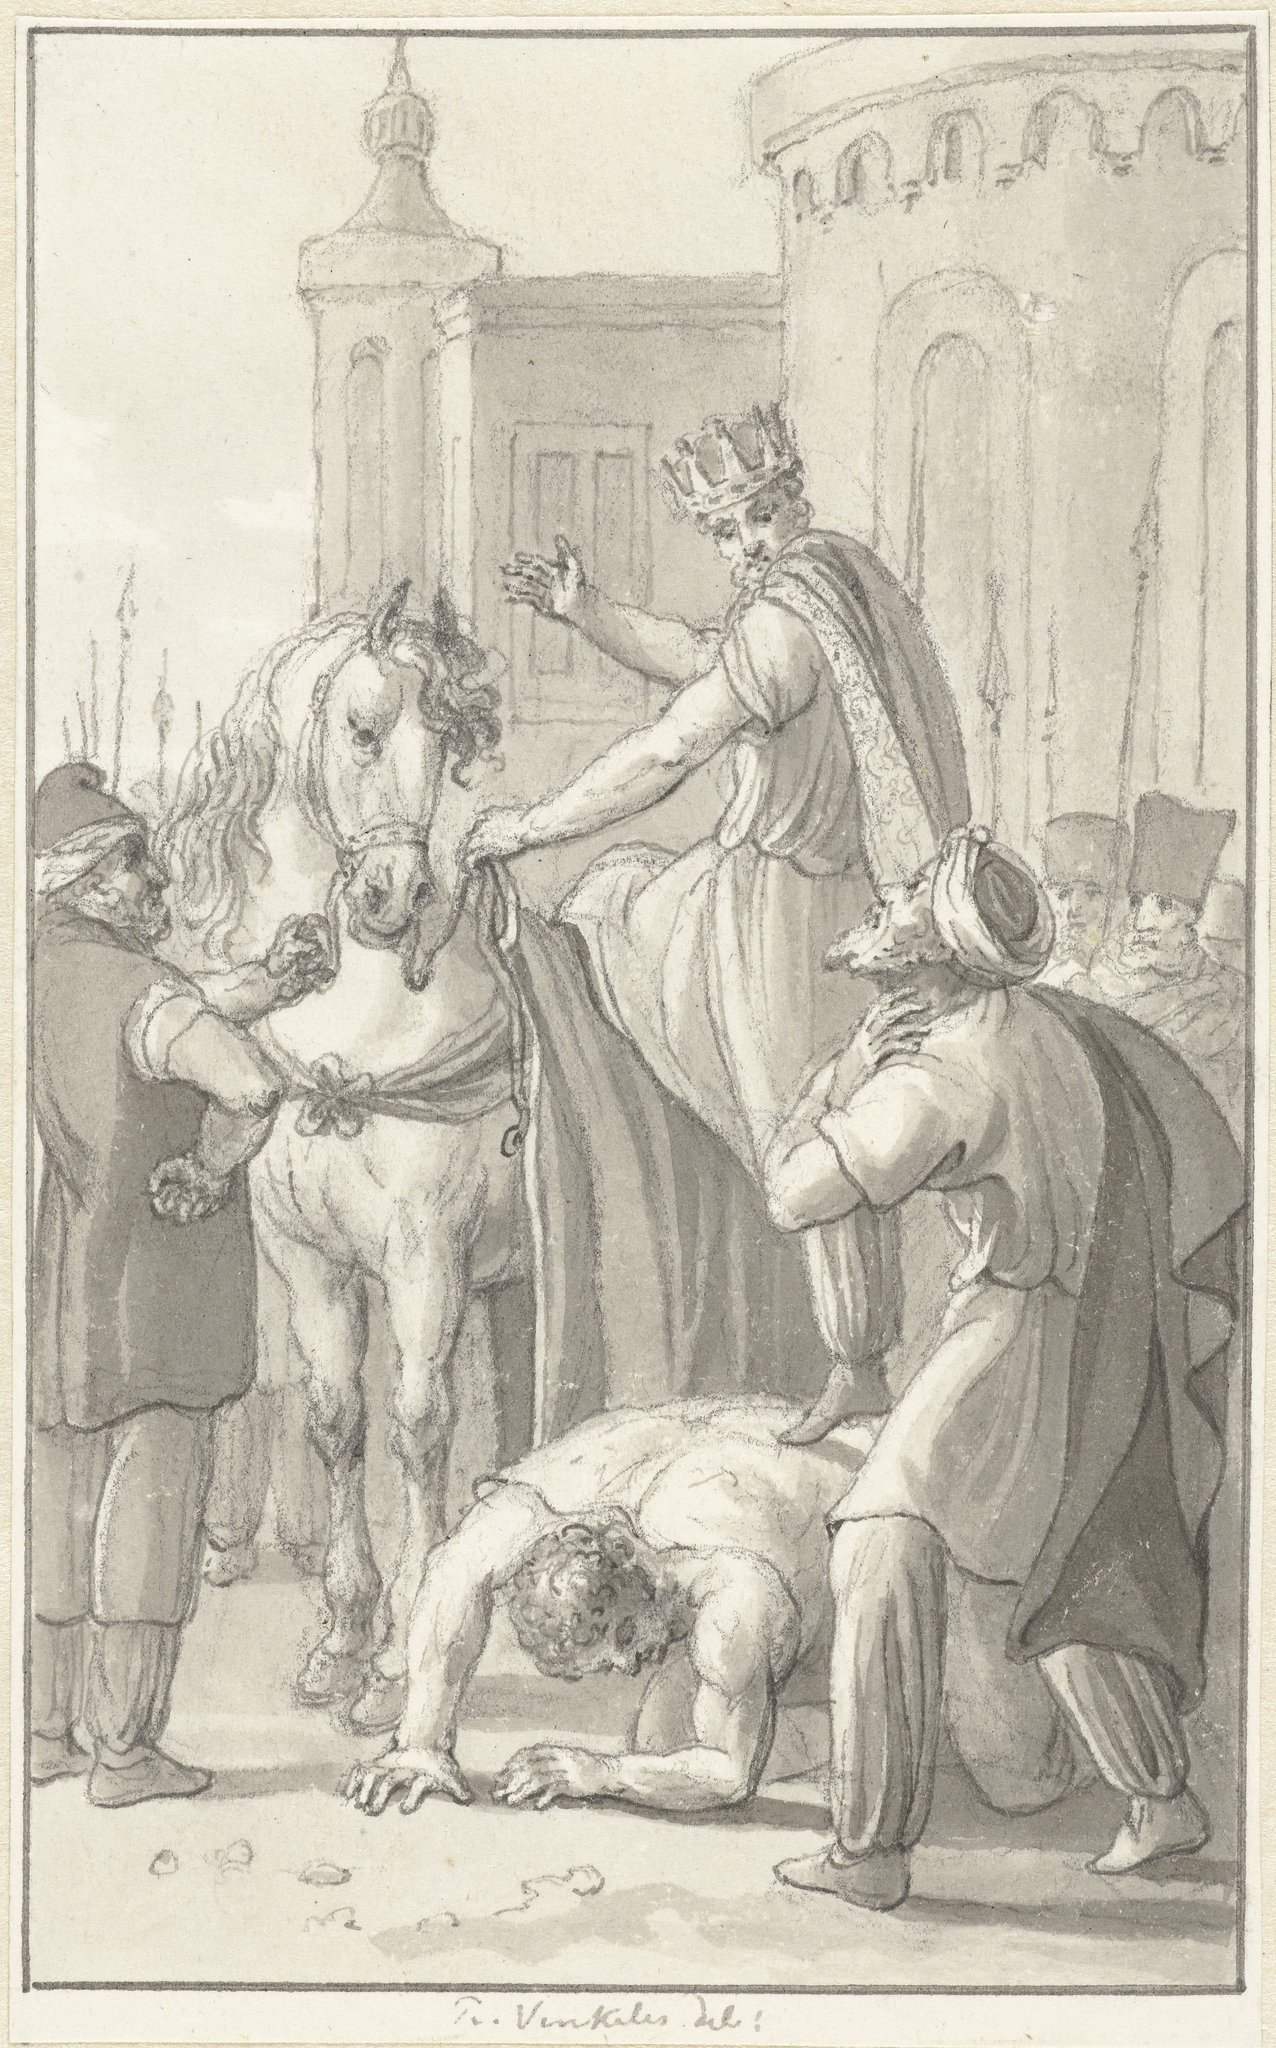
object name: drawing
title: Keizer Valerianus in krijgsgevangenschap bij de Perzische koning Sapor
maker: reinier vinkeles (i)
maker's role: draughtsman, print maker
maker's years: 1741-1816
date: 1804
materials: ink, paper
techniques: brush, pen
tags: male persons from classical history (sapor) - aggressive relationships of person from classical history, suffering, misfortune of emperor valerian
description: Ontwerp voor gravure door Ludwig Portman in M. Stuart's `Romeinsche Geschiedenissen', 1804, dl. 29 t.o. p. 68.